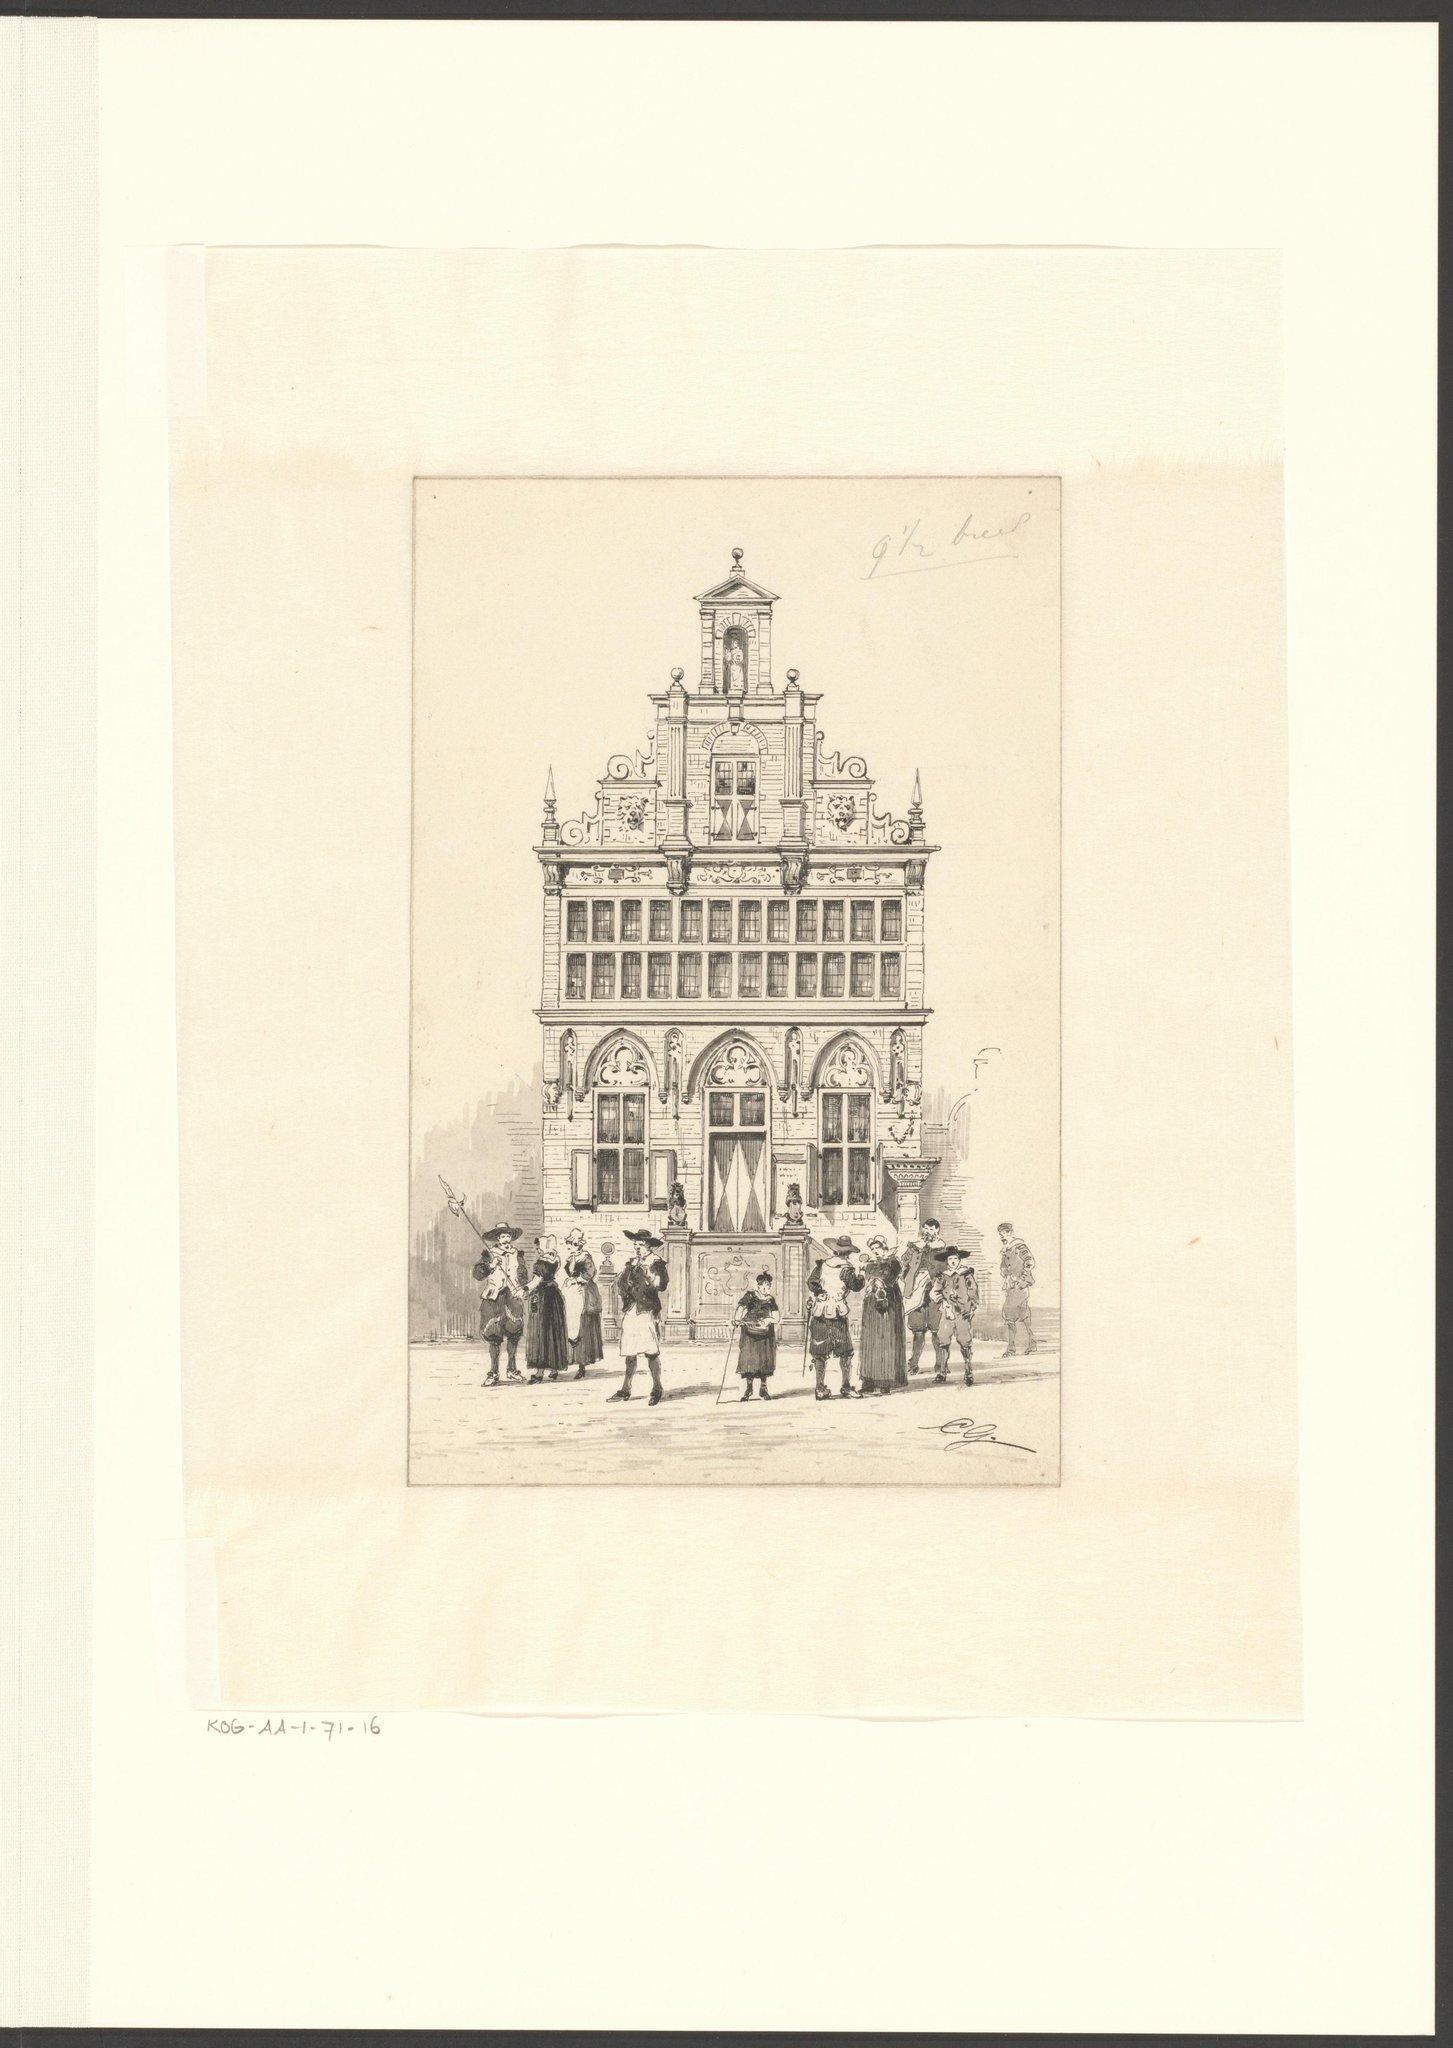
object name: drawing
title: Gezicht op het oud-Hollands stadhuis gebouwd voor de tentoonstelling van Voedingsmiddelen op het Museumplein van 1887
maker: johan conrad greive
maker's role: draughtsman, painter, print maker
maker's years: 1837-1891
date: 1887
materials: ink, paper, pencil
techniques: brush, pen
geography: amsterdam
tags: trade exhibition, industries fair, city-view in general; 'veduta'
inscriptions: signature: ‘C.G.’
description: Onderwerpsrubriek binnen de Atlas Amsterdam: Tentoonstellingen (chronologisch).